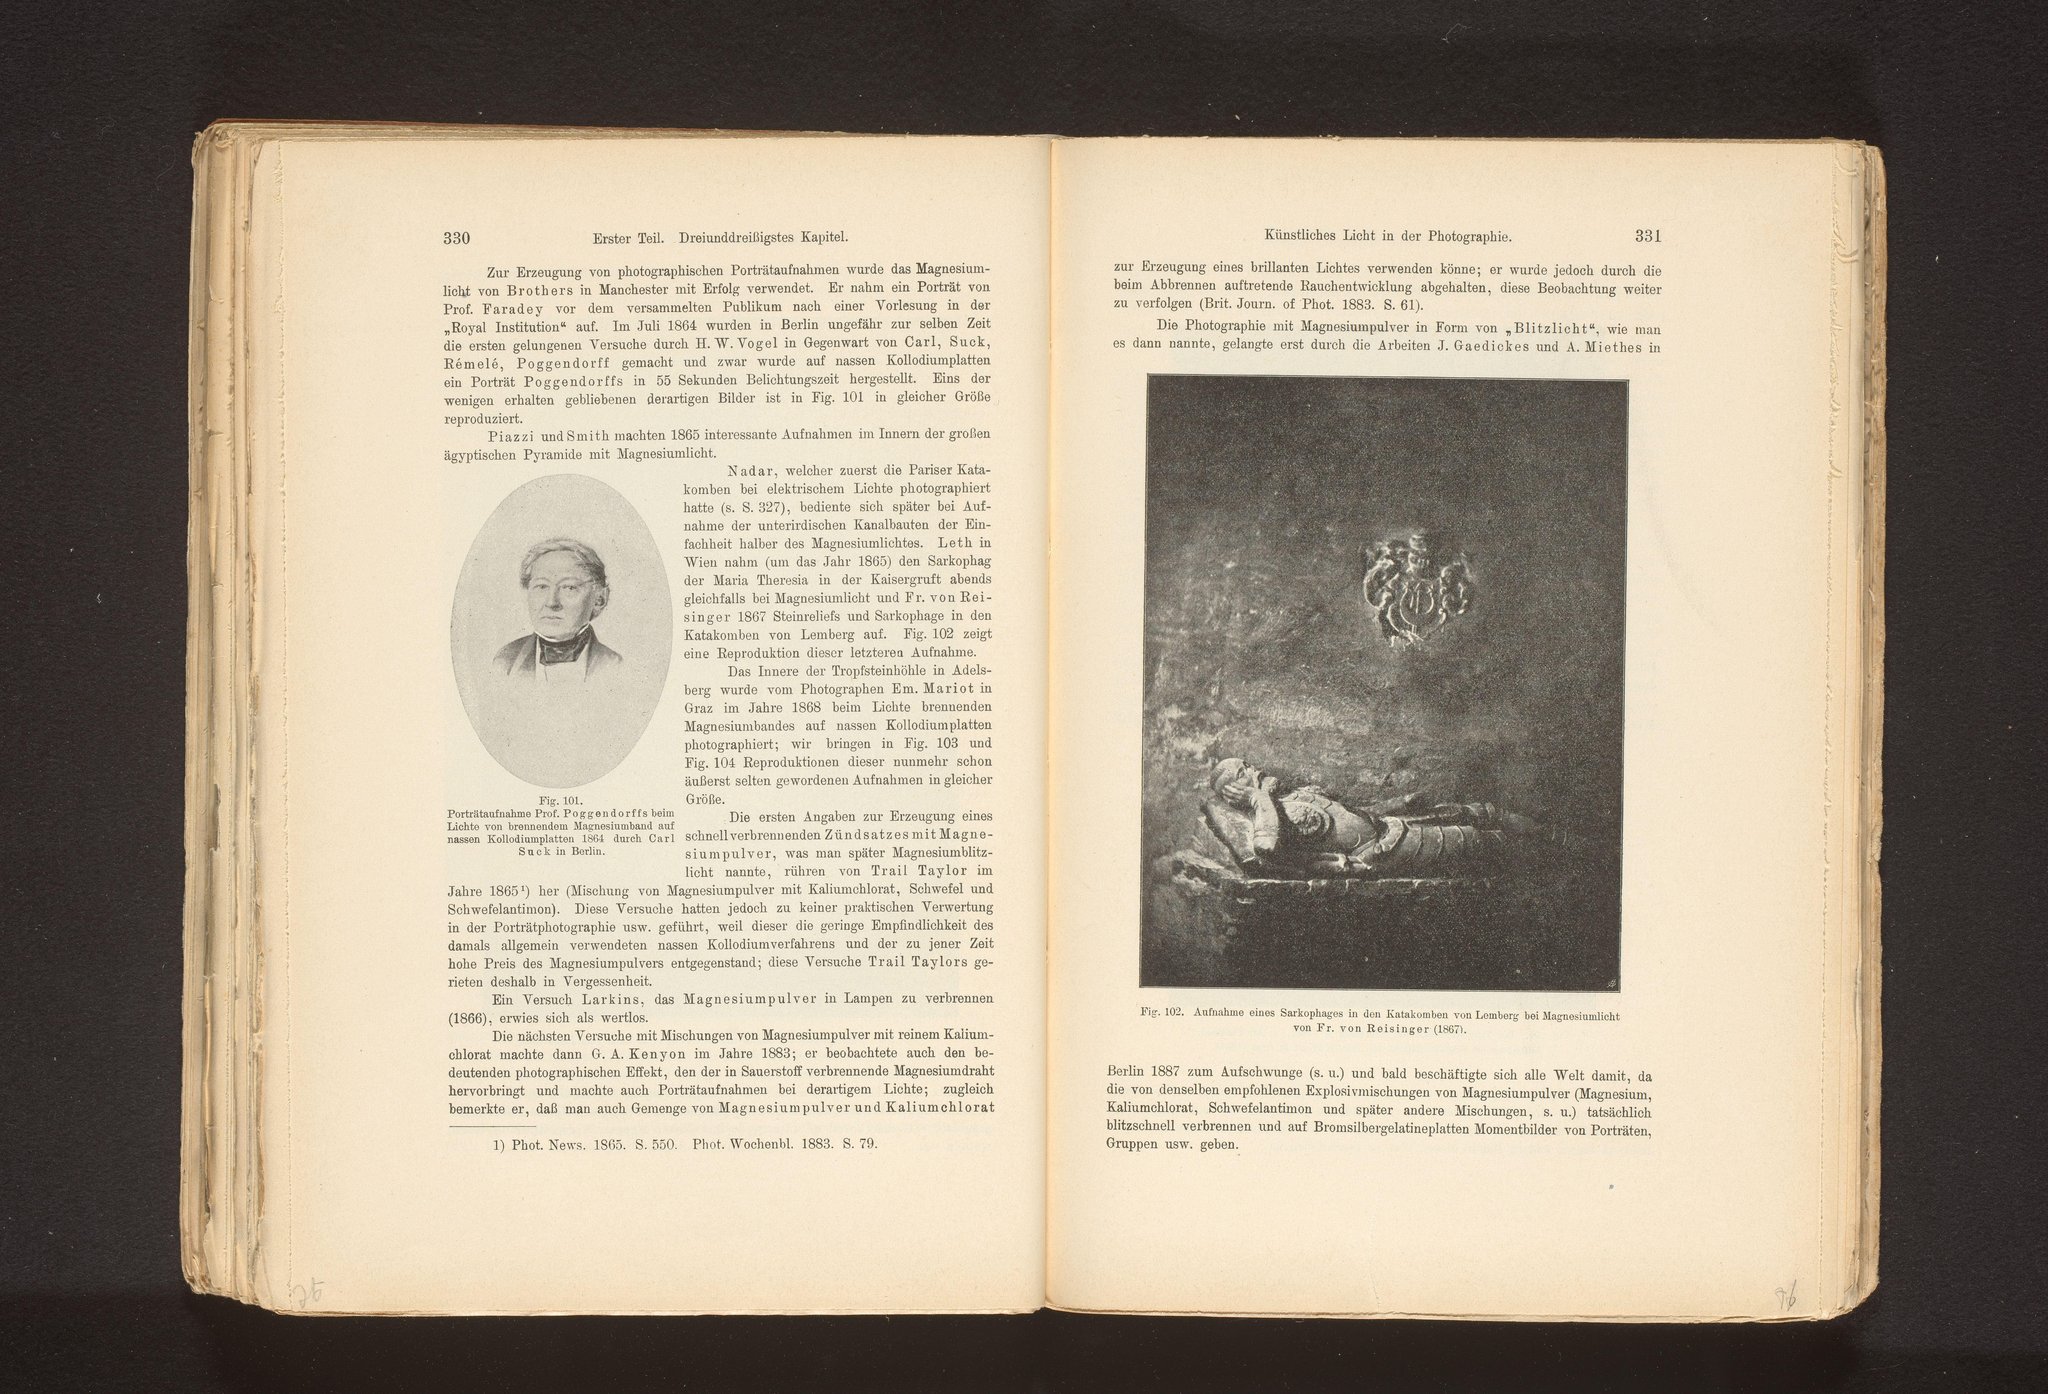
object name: photomechanical print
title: Sarcofaag in de Catacomben van Lviv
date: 1900-1905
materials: paper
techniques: autotype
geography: lvov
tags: sarcophagus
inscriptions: number: ‘Fig. 102.’